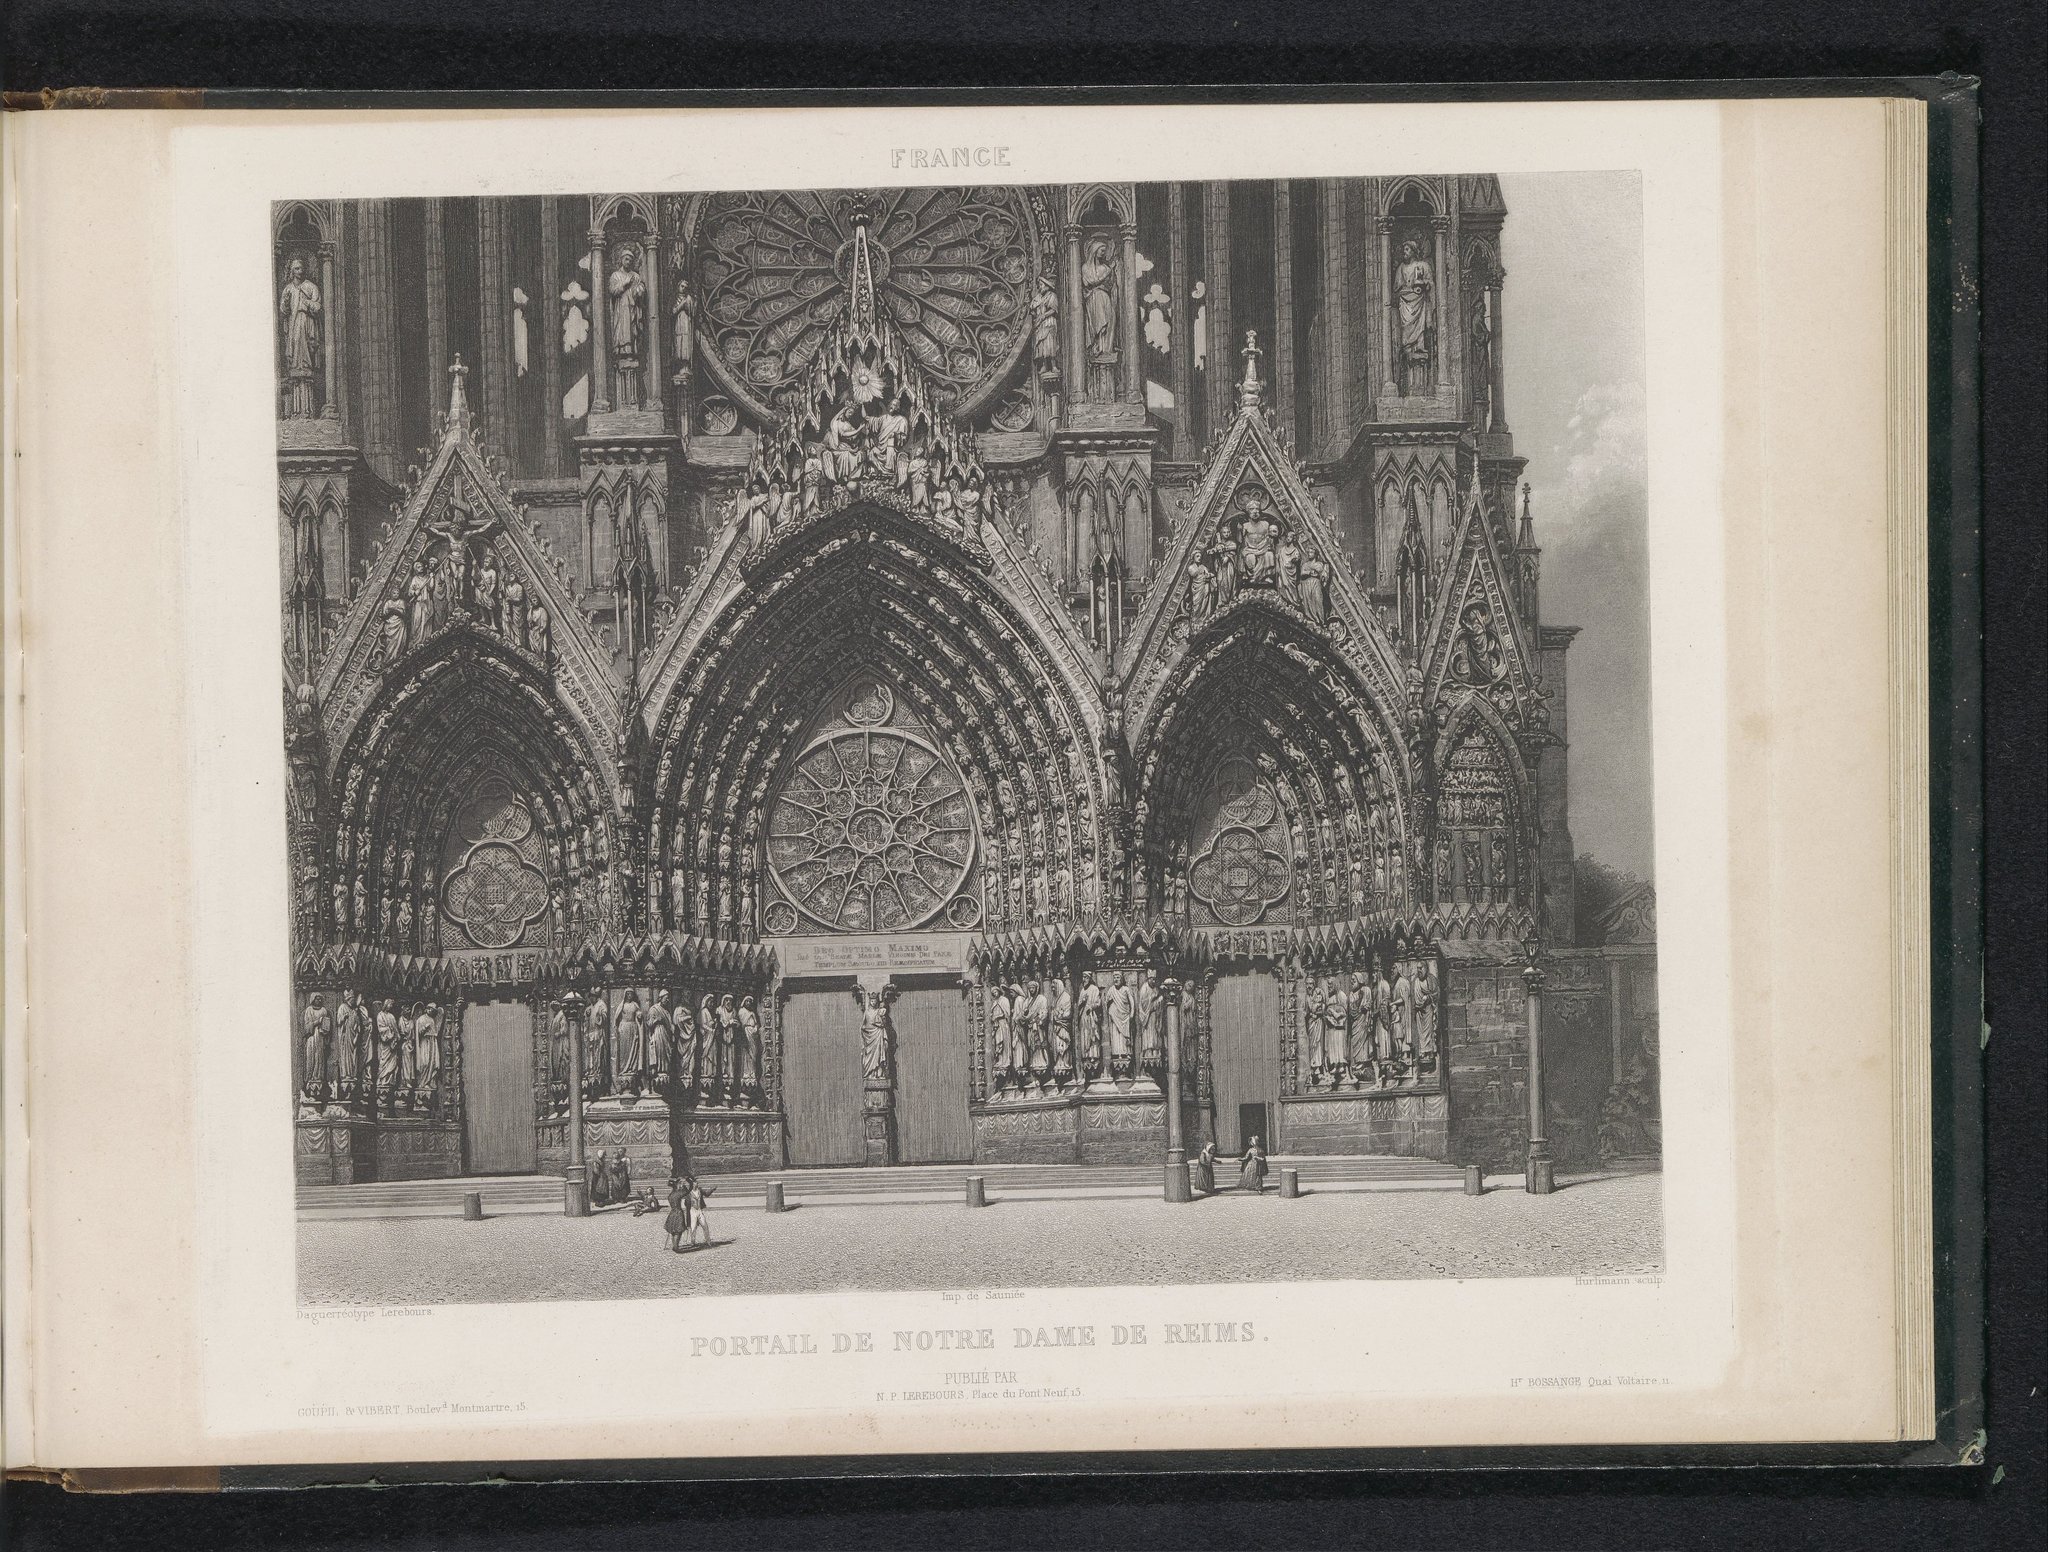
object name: page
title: France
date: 1839-1841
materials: paper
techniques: aquatint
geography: reims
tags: parts of church exterior and annexes: portal, façade (of house or building)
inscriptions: inscription: ‘Rittner & Goupil Boulevd Montmartre 15’, inscription: ‘Hr. Bossance Quai Voltaire 11’, inscription: ‘N.P. Lerebours Place du Pont Neuf 15’